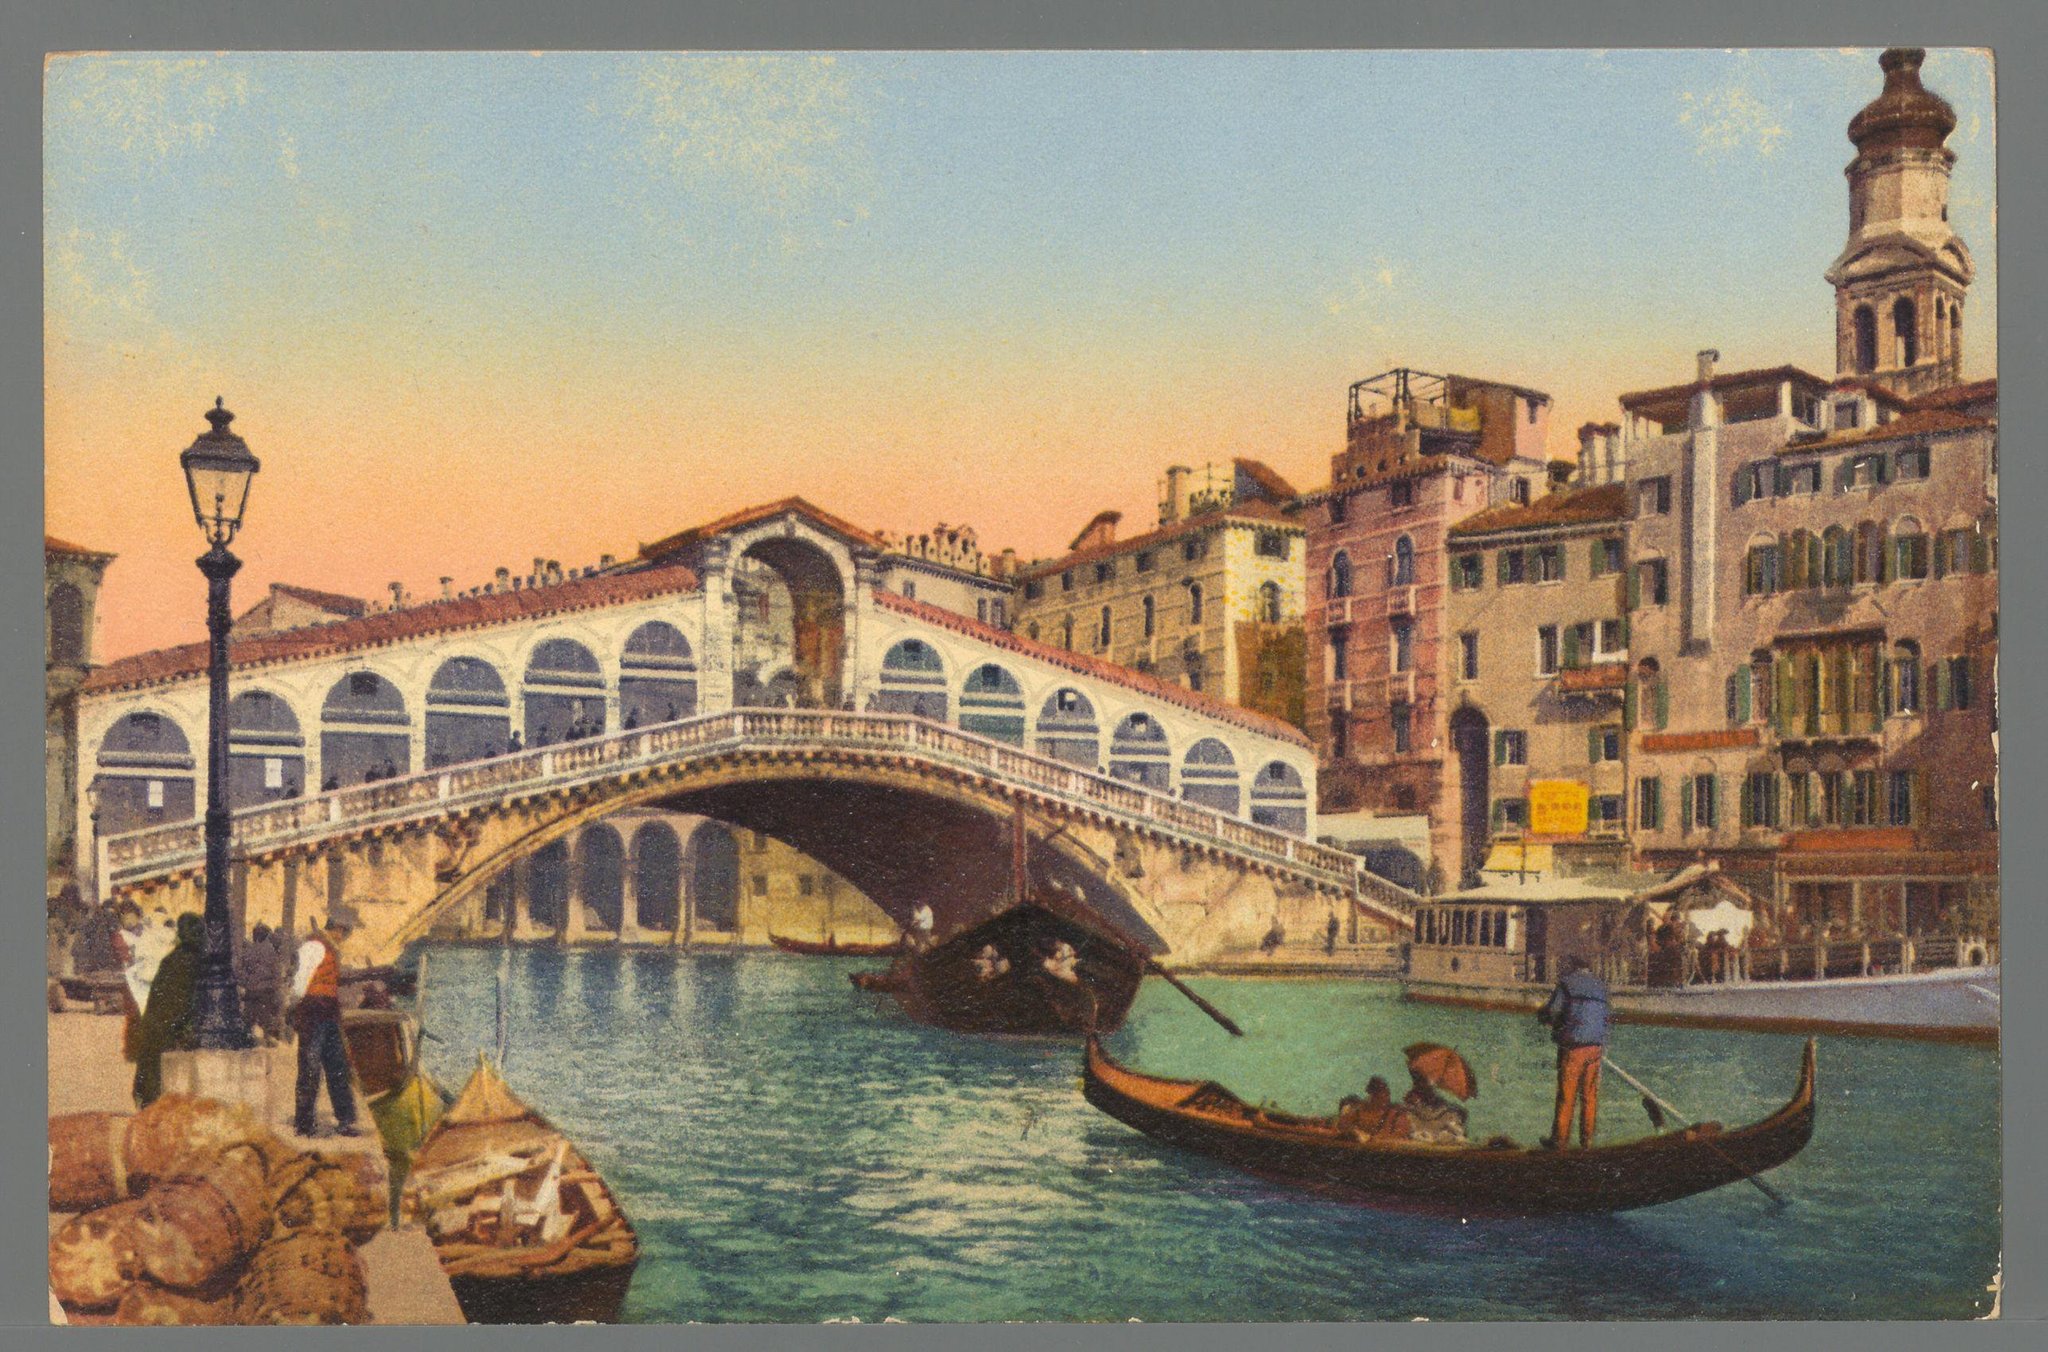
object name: print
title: Venezia. Ponte di Rialto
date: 1903-1925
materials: cardboard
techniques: lithograph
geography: zurich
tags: bridge in city with structures, i.e. shops, houses, e.g. ponte vecchio in florence, city-view, and landscape with man-made constructions (+ city(-scape) with figures, staffage)